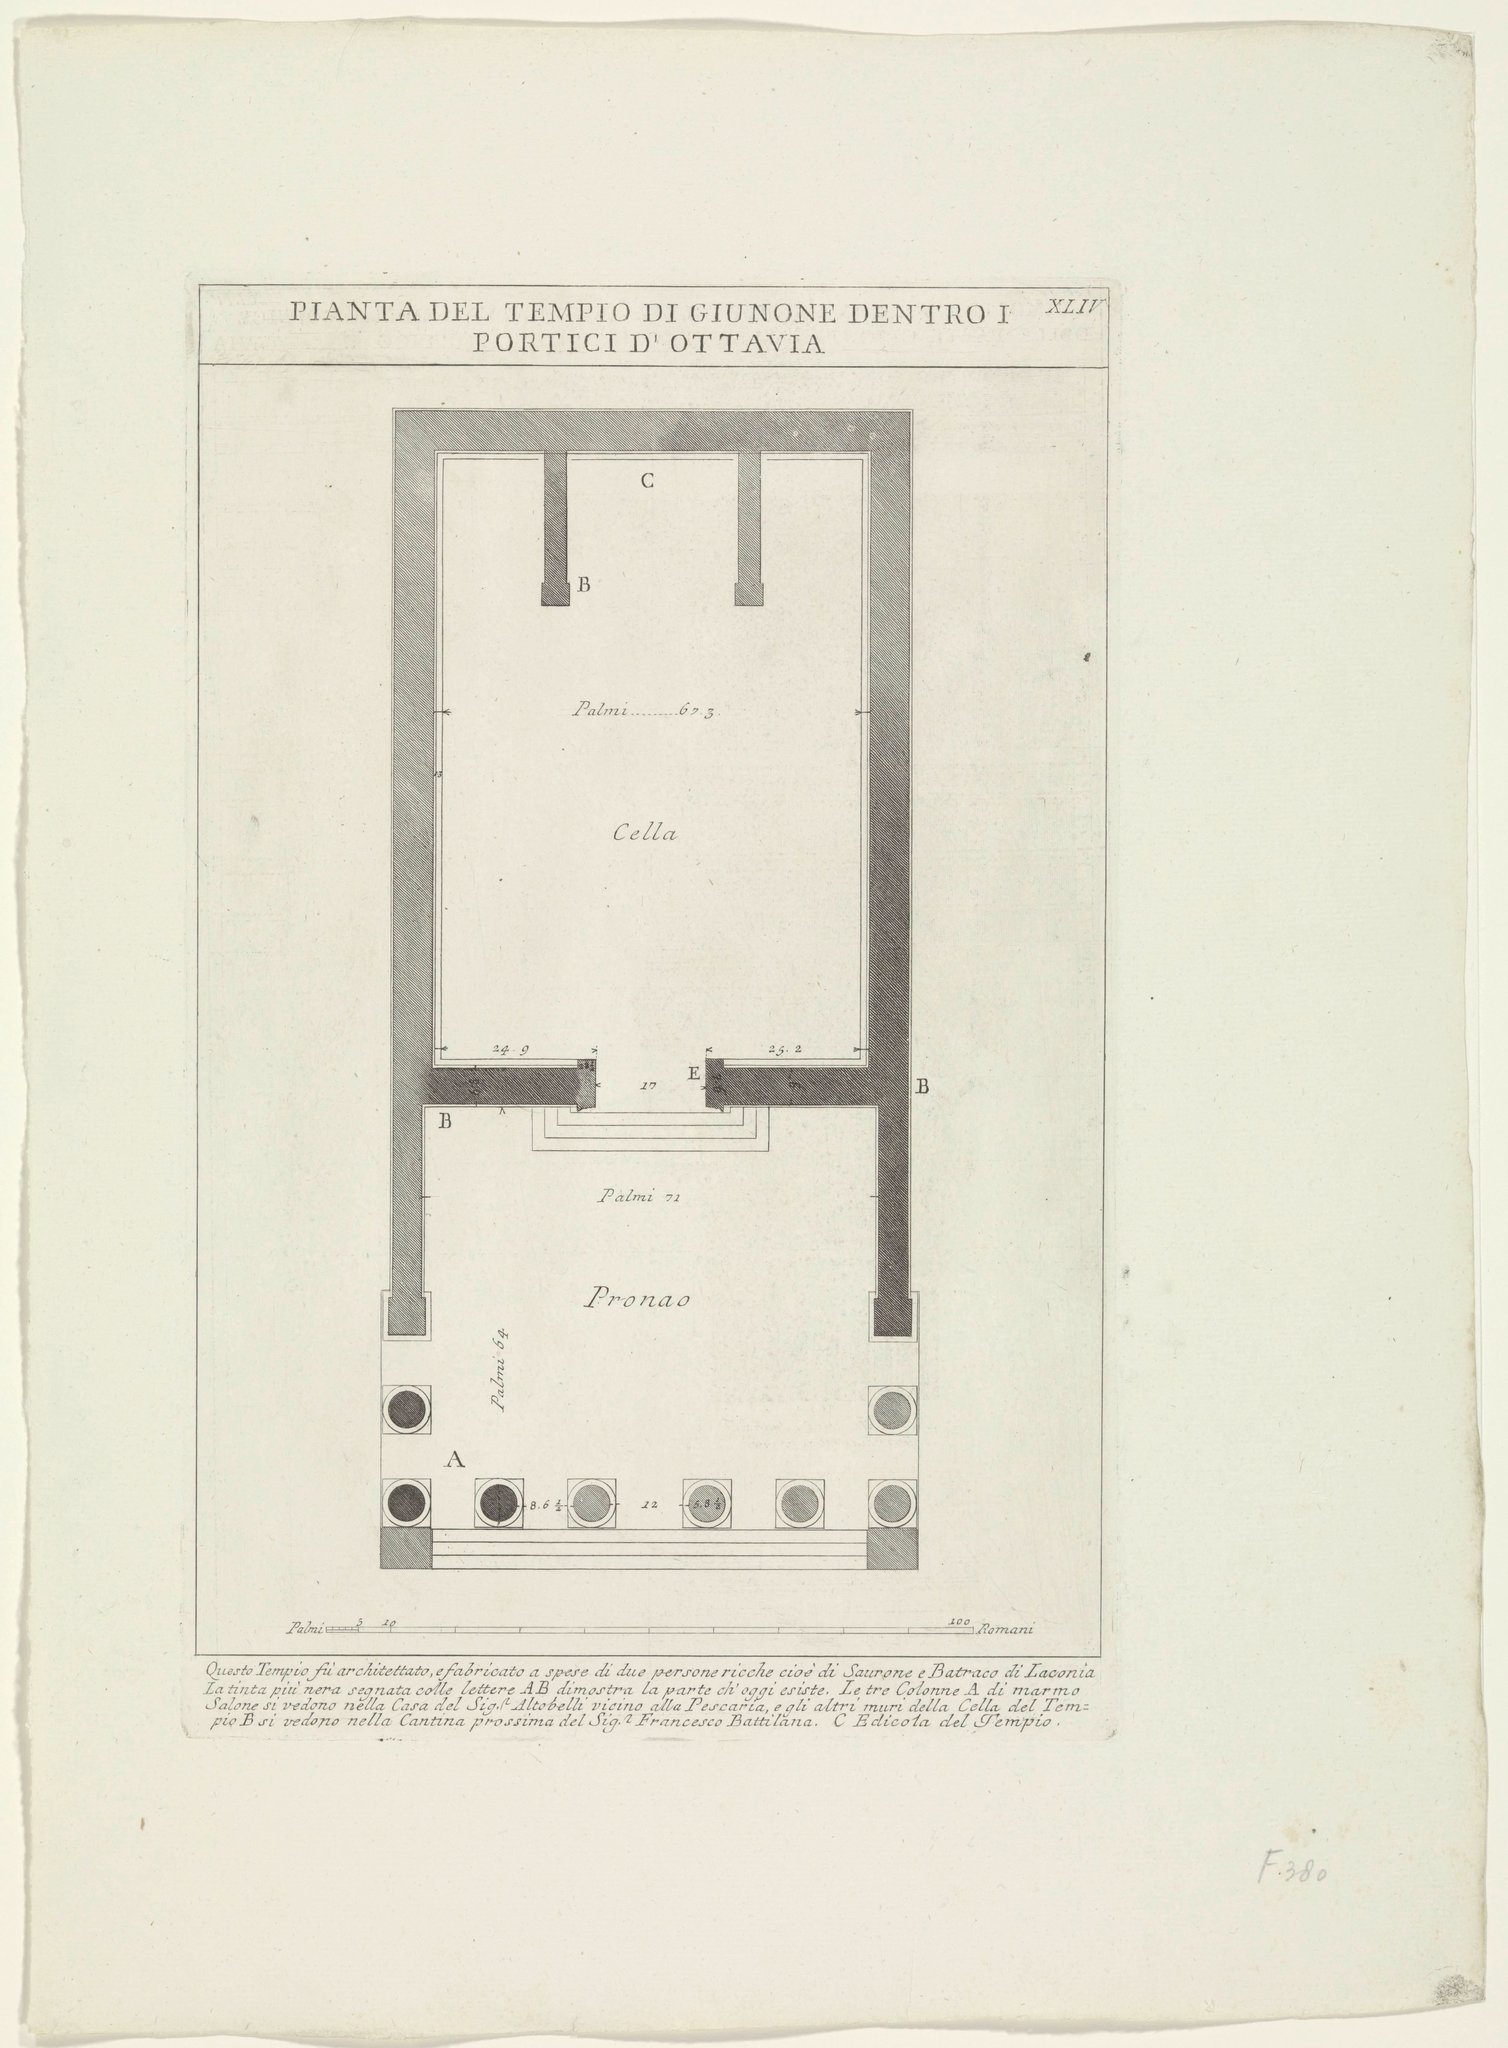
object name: print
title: Le Antichità Romane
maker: giovanni battista piranesi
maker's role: designer, draughtsman, print maker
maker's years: 1720-1778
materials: paper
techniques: etching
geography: rome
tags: temple, shrine ~ roman religion, plan ~ architecture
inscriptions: collector's mark: Lugt 2228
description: Deze prent werd toegevoegd in de tweede editie van de serie 'Le Antichità Romane'. Piranesi deed meer dan acht jaar voorstudie voor deze 250 platen tellende serie die in vier volumes werd uitgegeven. Hij produceerde de prenten tussen ca. 1756 en 1757. In 1784 werd de tweede editie uitgegeven. De serie bevat ook prenten door of naar andere prentmakers, onder wie Francesco Bianchini en Girolamo Rossi.